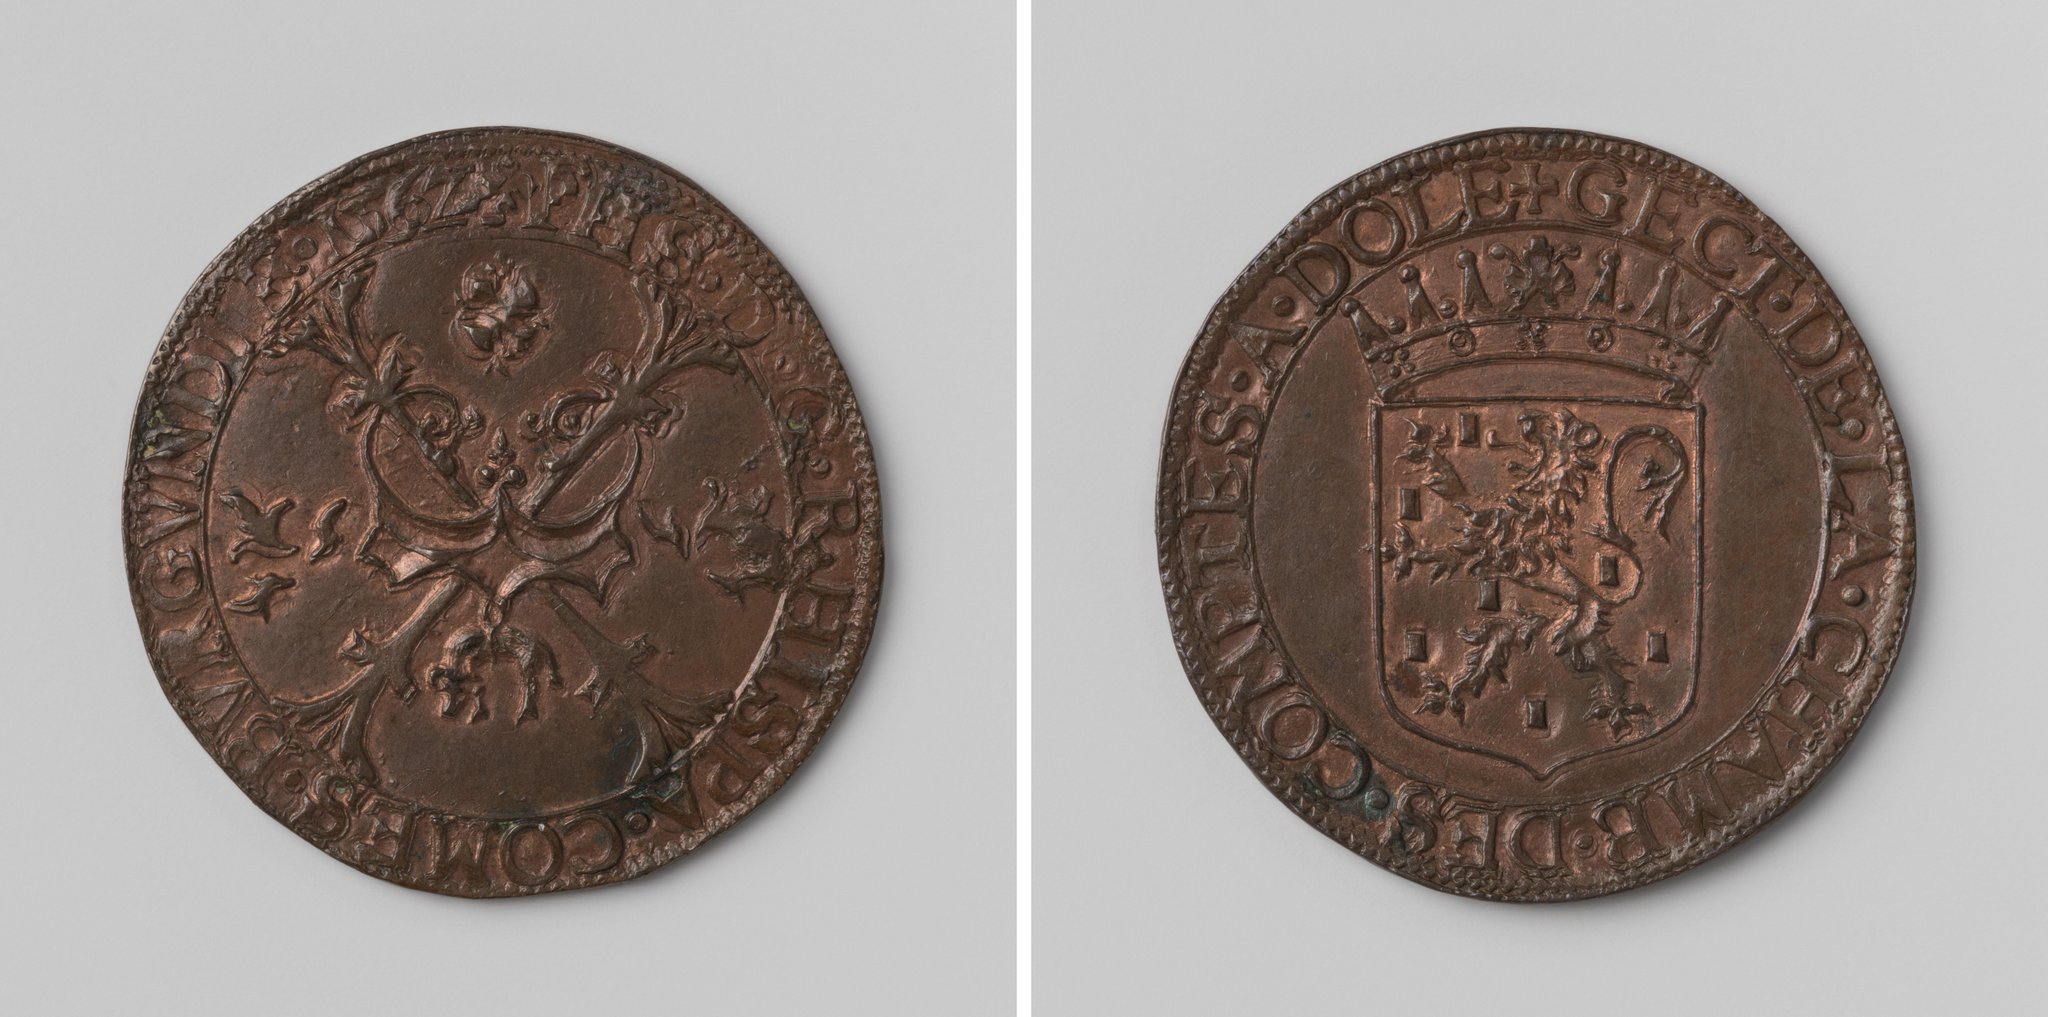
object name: jeton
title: Filips II, koning van Spanje, rekenpenning van de rekenkamer van Bourgondië te Dole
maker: Anonymous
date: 1562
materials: copper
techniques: striking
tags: philip ii of spain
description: Koperen penning. Voorzijde: vuurslag waar orde van Gulden Vlies aan hangt op Bourgondisch kruis, omgeven door vonken binnen omschrift. Keerzijde: gekroond wapenschild binnen omschrift.